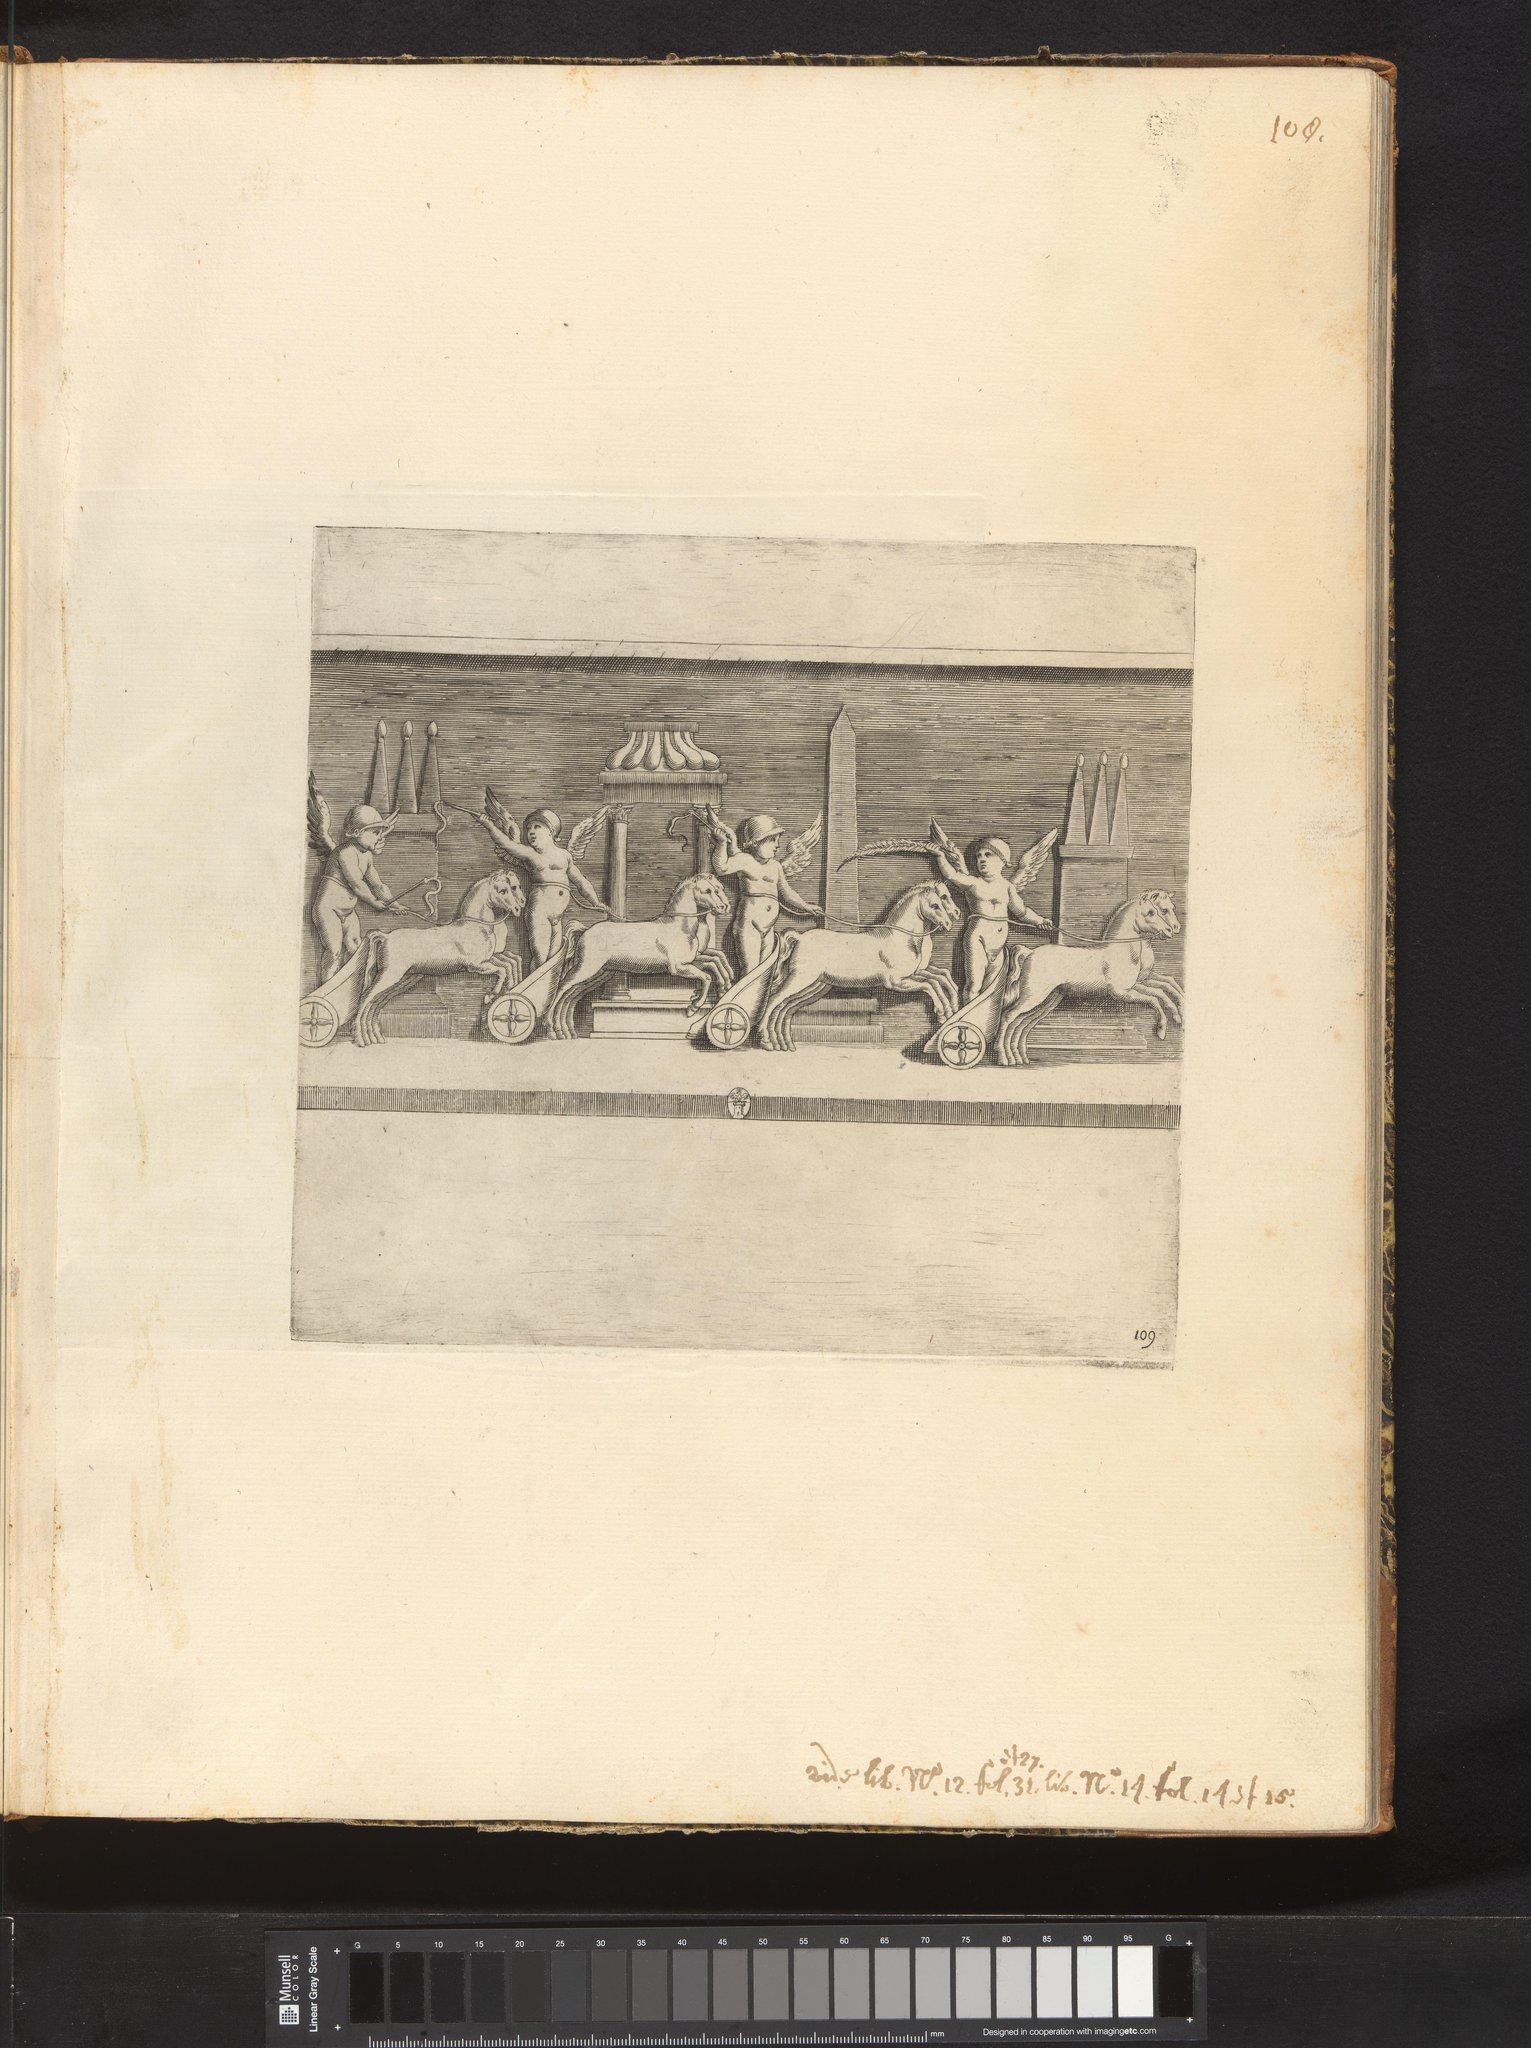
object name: print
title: Galleria Giustiniana del Marchese Vincenzo Giustiniani II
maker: gabriel ladame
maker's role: print maker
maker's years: 1613-1679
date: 1636-1647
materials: paper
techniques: engraving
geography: rome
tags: kitchen, slaughtered ox or pig, piece of sculpture, reproduction of a piece of sculpture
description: Bas-reliëf met de voorstelling van een keuken. Twee vrouwen staan bij verschillende geslachte dieren. Op de zetel van de linkervrouw het wapenschild van Vincenzo Giustiniani. Prent maakt deel uit van een album met een serie prenten naar de sculpturen in de verzameling in de Galleria Giustiniani te Rome.